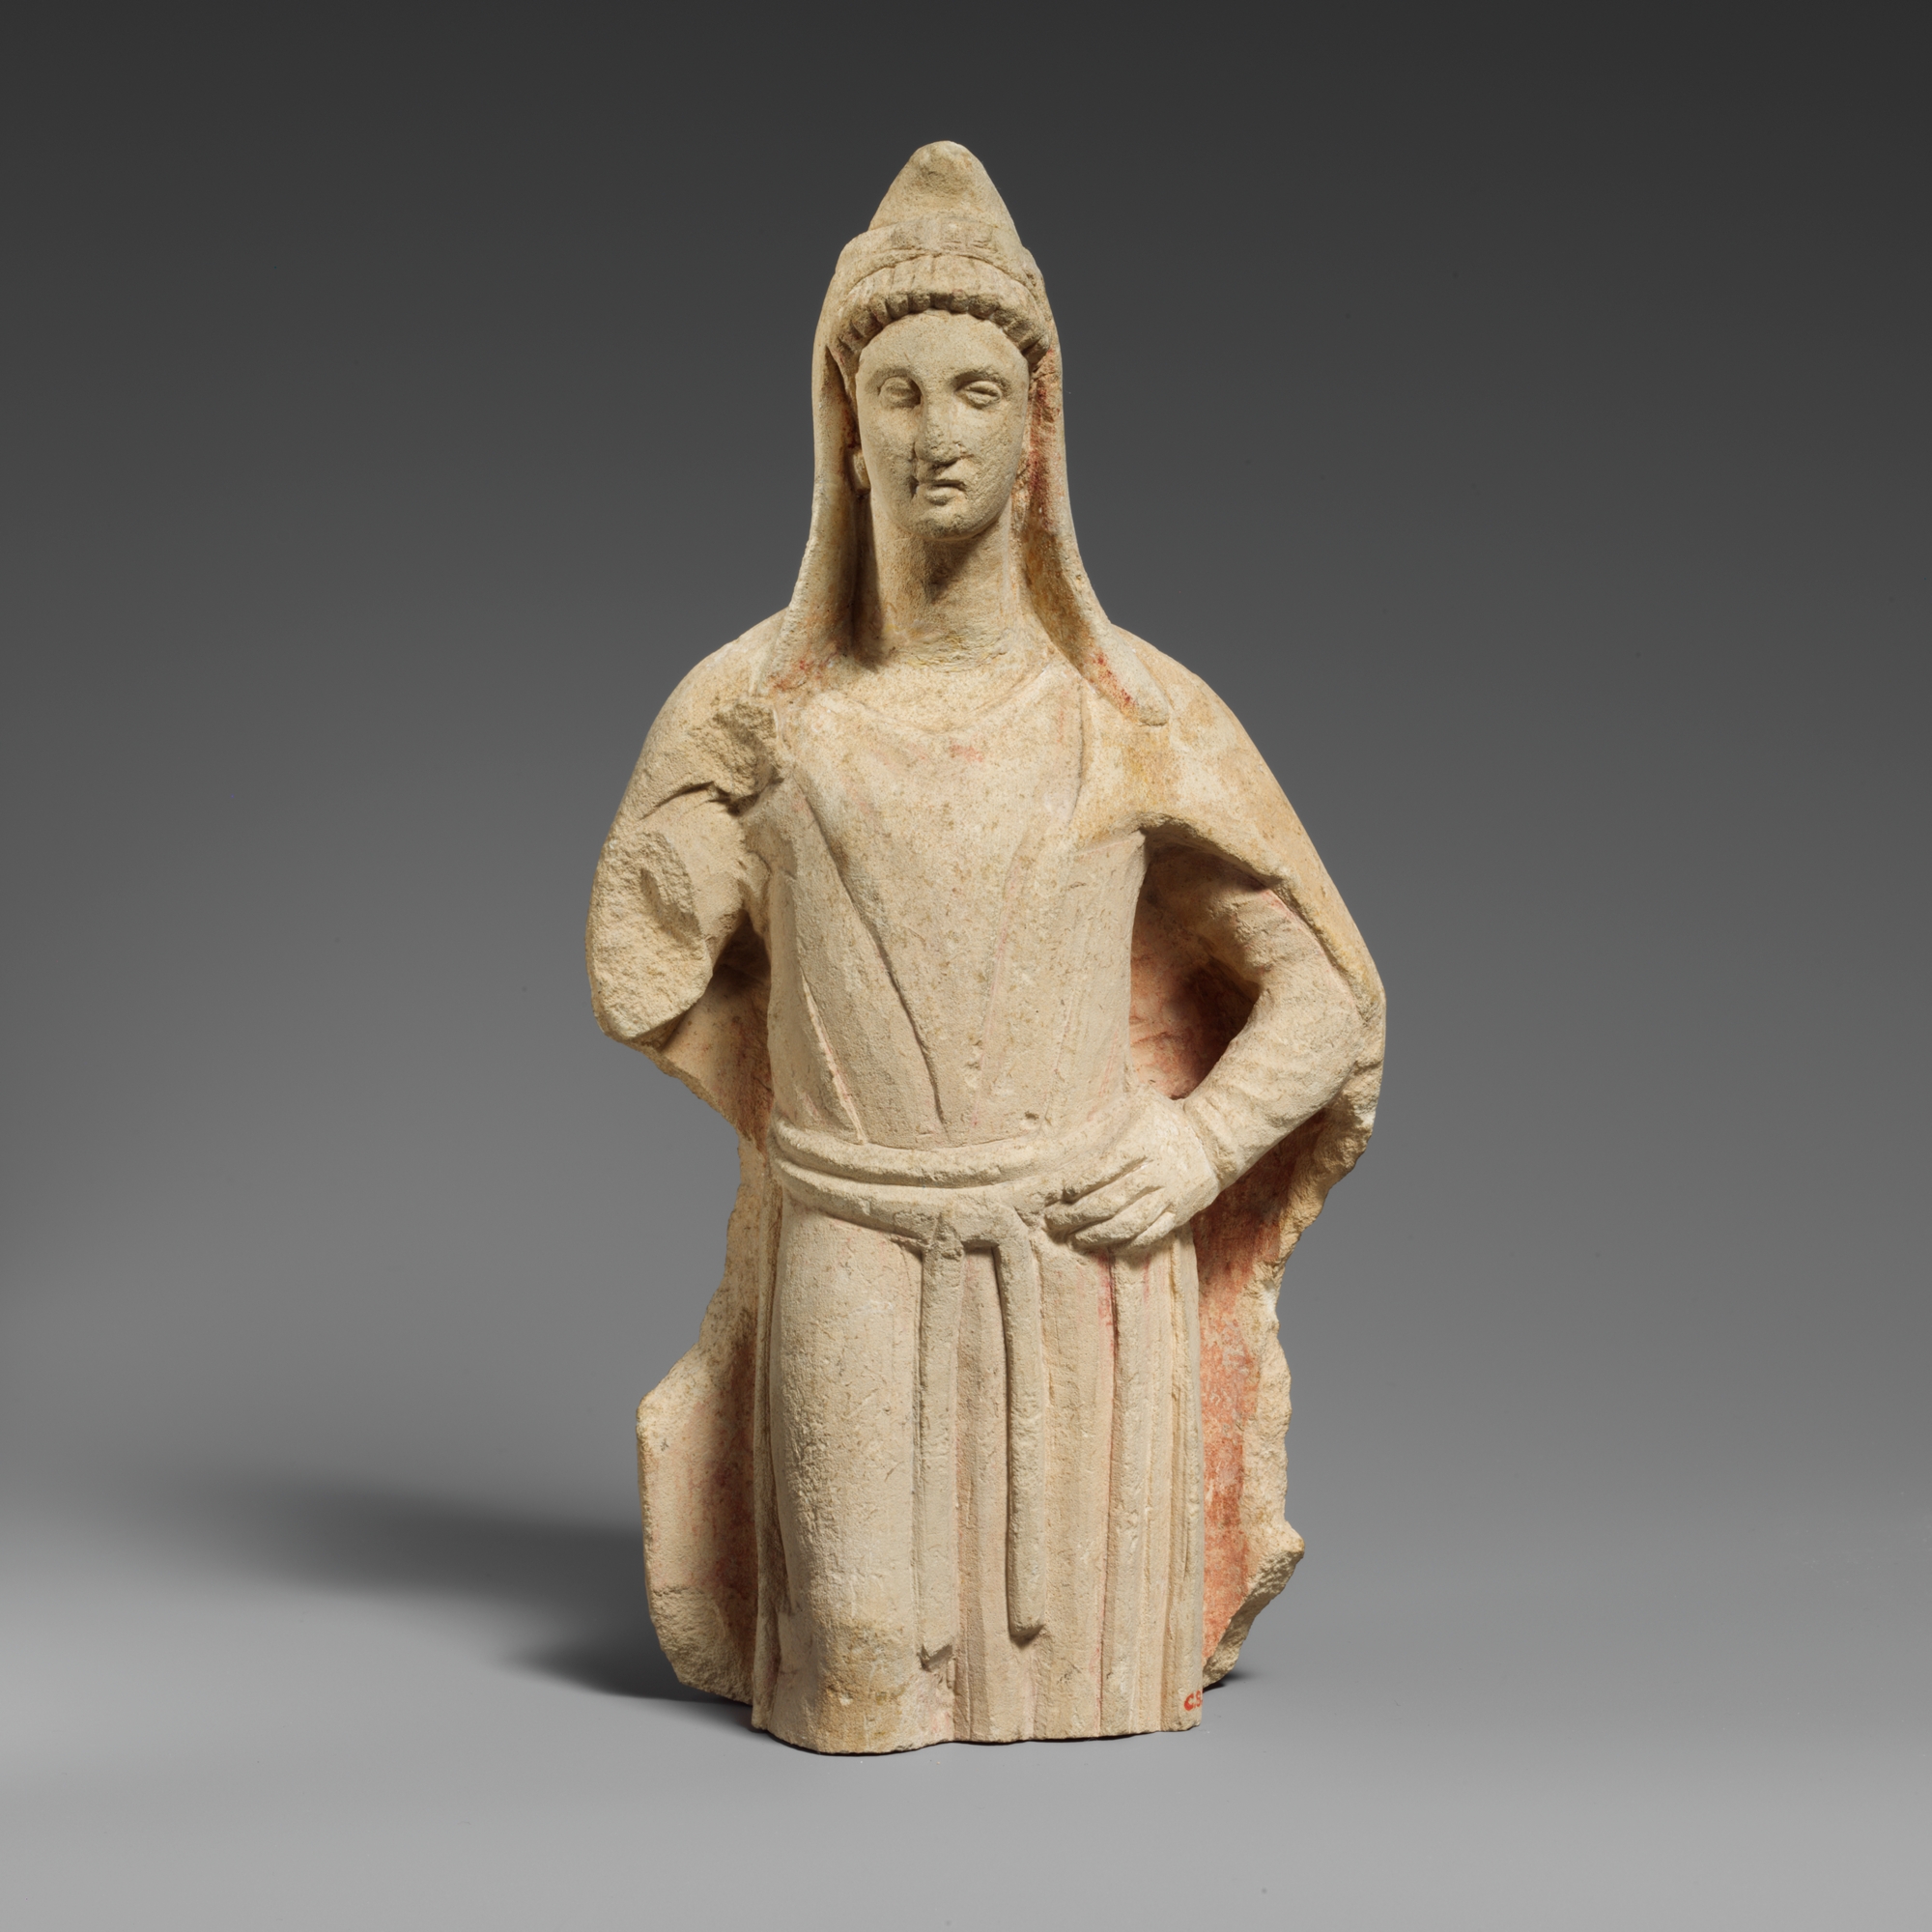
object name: statuette of a votary, male, oriental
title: Limestone statuette of an oriental god or hero (?)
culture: cypriot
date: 300-201 BCE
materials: limestone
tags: gods